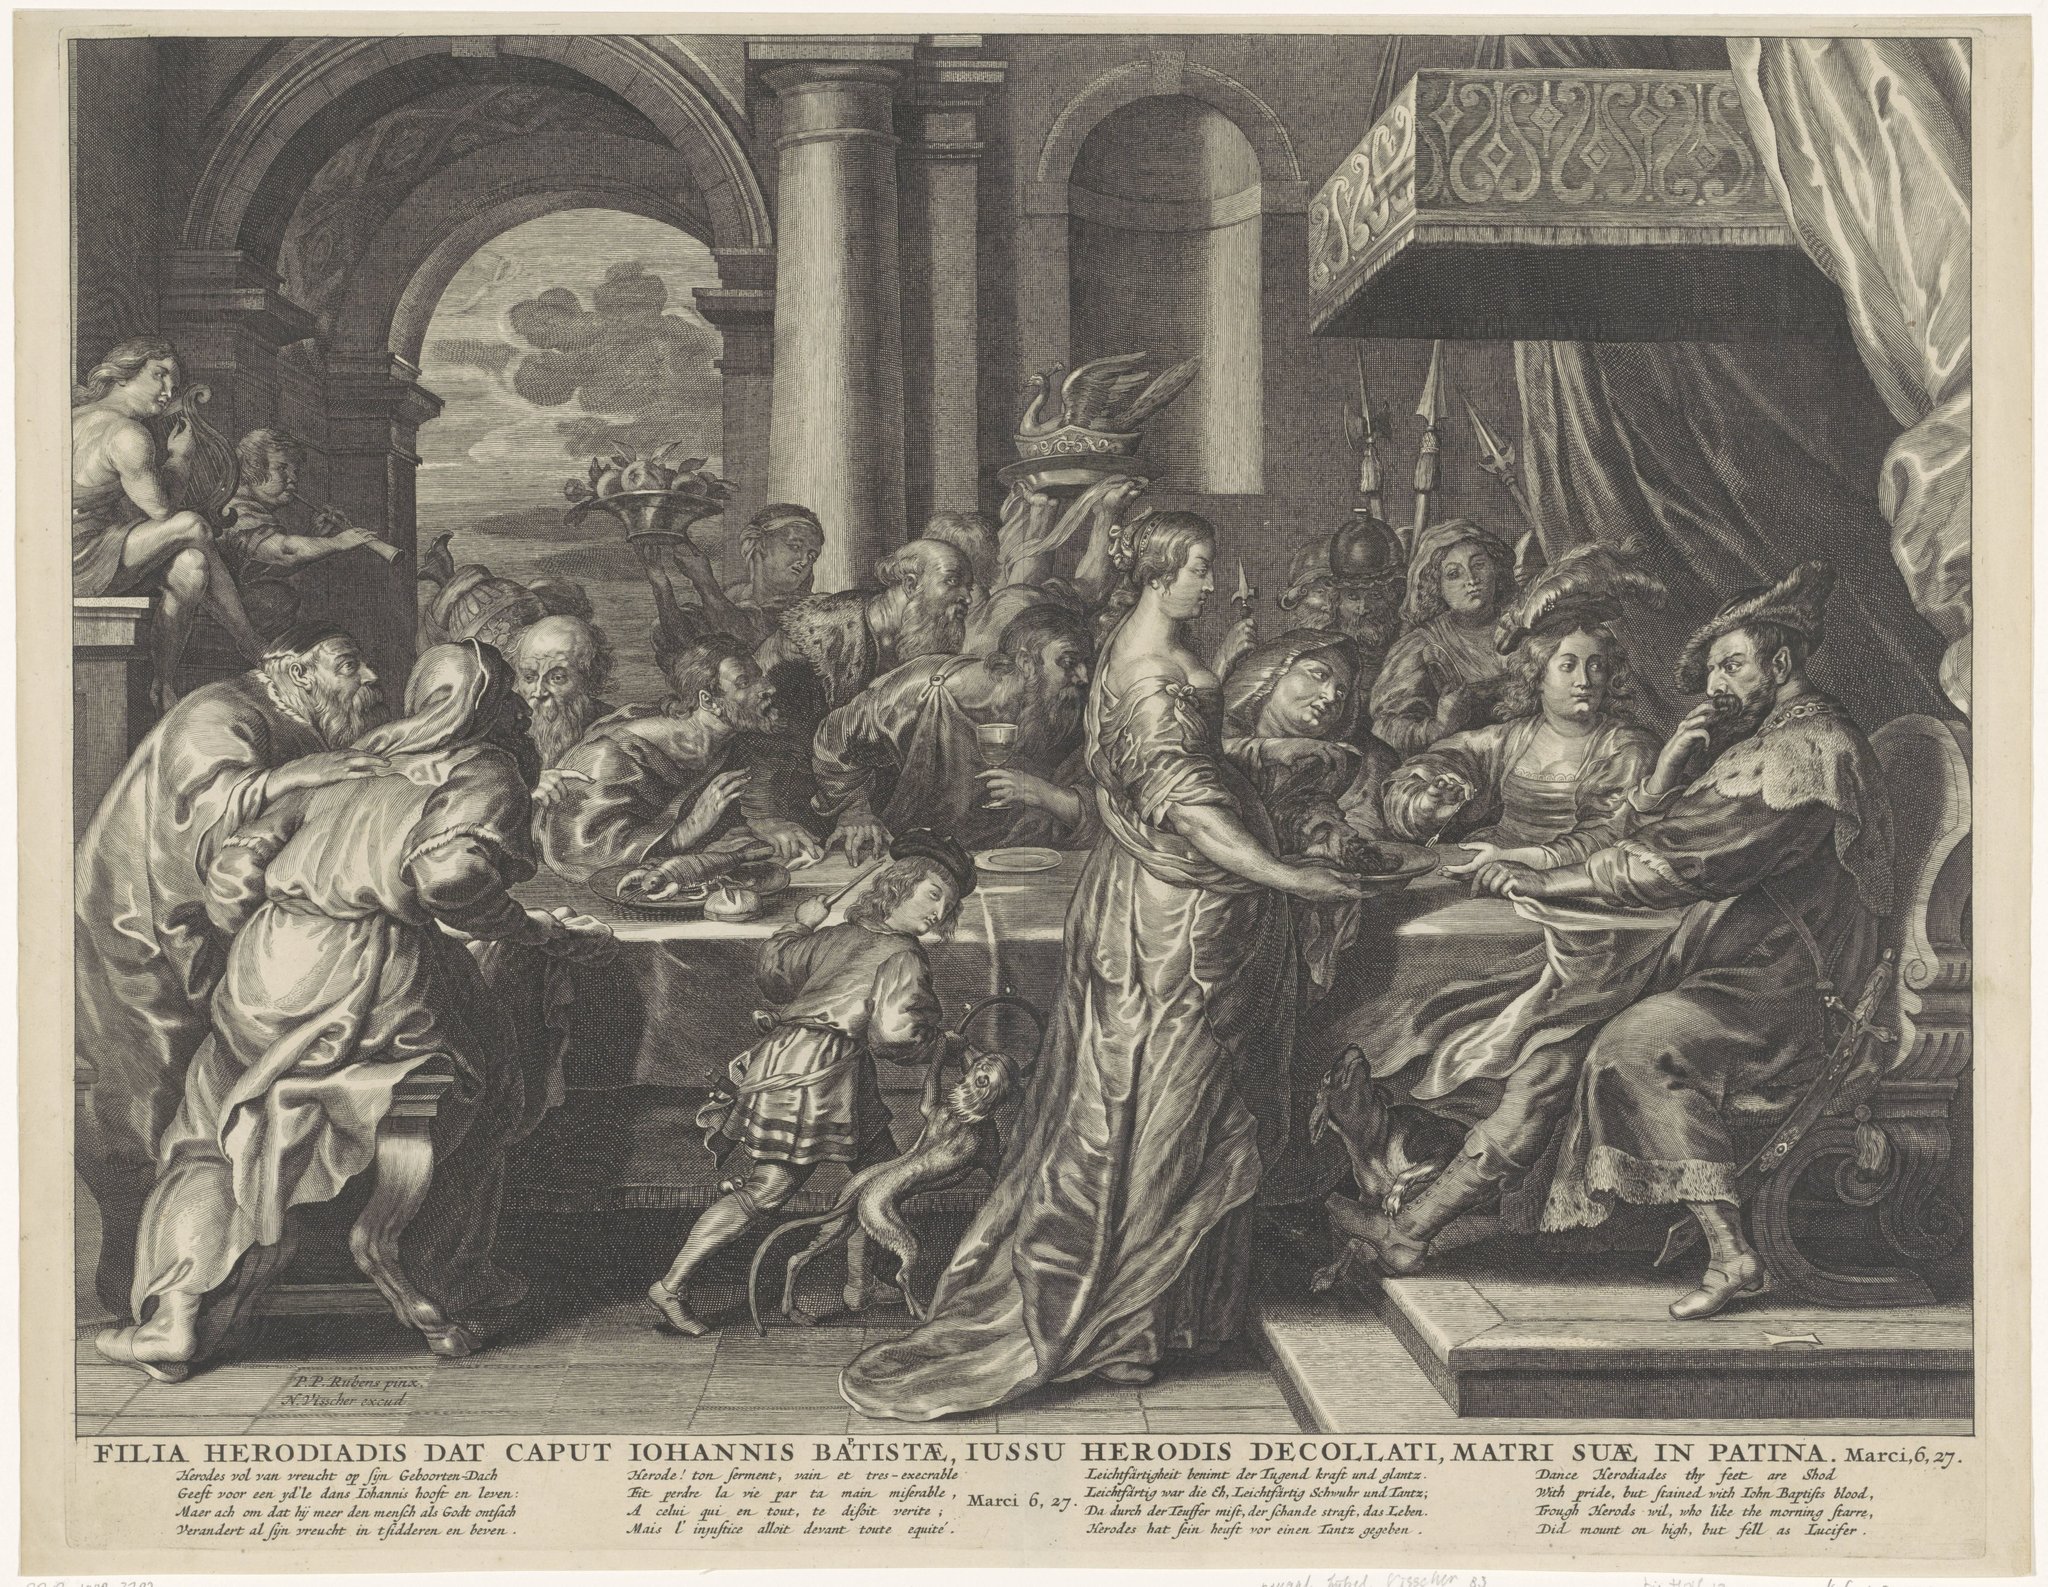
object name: print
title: Filia Herodiadis dat caput Iohannis Baptistae, iussu Herodis decollati, matri suae in patina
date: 1652-1702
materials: paper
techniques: engraving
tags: salome with the head of john the baptist on a dish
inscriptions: collector's mark: Lugt 2228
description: De Amsterdamse uitgever Claes Jansz. Visscher (II) produceerde vanaf de jaren ’30 van de zeventiende eeuw grote Bijbelse prenten op zogenaamd royaal-formaat papier (ca. 480 x 580 mm). Na zijn dood in 1652 zette zijn zoon Nicolaes Visscher (I) het bedrijf voort en zo ook de uitgave van Royaalbijbelprenten. Toen Nicolaes in 1679 overleed nam zijn zoon Nicolaes Visscher (II) het bedrijf over en gaf kort hierna, omstreeks 1680, een fondslijst uit. Hierin worden 130 prenten met Bijbelse voorstellingen op royaalpapier beschreven (zie documentatie J. van der Waals). Complete prentbijbels op royaal-formaat werden door vader en zoon Nicolaes Visscher uitgegeven onder de titel Historiae Sacrae Veteris et Novi Testamenti. De bladen werden echter ook los verkocht en konden worden gecombineerd met Royaalbijbel-prenten van andere uitgevers. Verschillende Amsterdamse uitgevers brachten namelijk ook bijbelprenten op royaal-formaat uit, onder wie Clement de Jonghe en Cornelis Danckerts. De door de firma Visscher uitgegeven prenten zijn veelal vervaardigd door anonieme prentmakers naar voorbeeld van verschillende zestiende- en zeventiende-eeuwse Bijbelse prenten en prentreeksen. Veelal moesten de composities worden aangepast aan het grotere en langgerekte royaal-formaat. Daarnaast zijn er ook grote bladen van bekende prentmakers zoals Jan van Londerseel, Pieter Nolpe, Jacques de Gheyn (II) en Jan Harmensz. Muller opgenomen in de categorie ‘Bybelsche Figuren, op Royaal-bladen’ in de fondslijst van Visscher. Prent mogelijk gebruikt in: Historiae Sacrae Veteris et Novi Testamenti (Royaalbijbel). Amsterdam: Nicolaes Visscher (I) en (II), [1652-1702]. In de fondslijst van Nicolaes Visscher II (ca. 1680) is het onderwerp van deze prent onder de titel 'Bybelsche Figuren, op Royaal-bladen. bestaande uyt de volgende historien.' als volgt genummerd: 83.